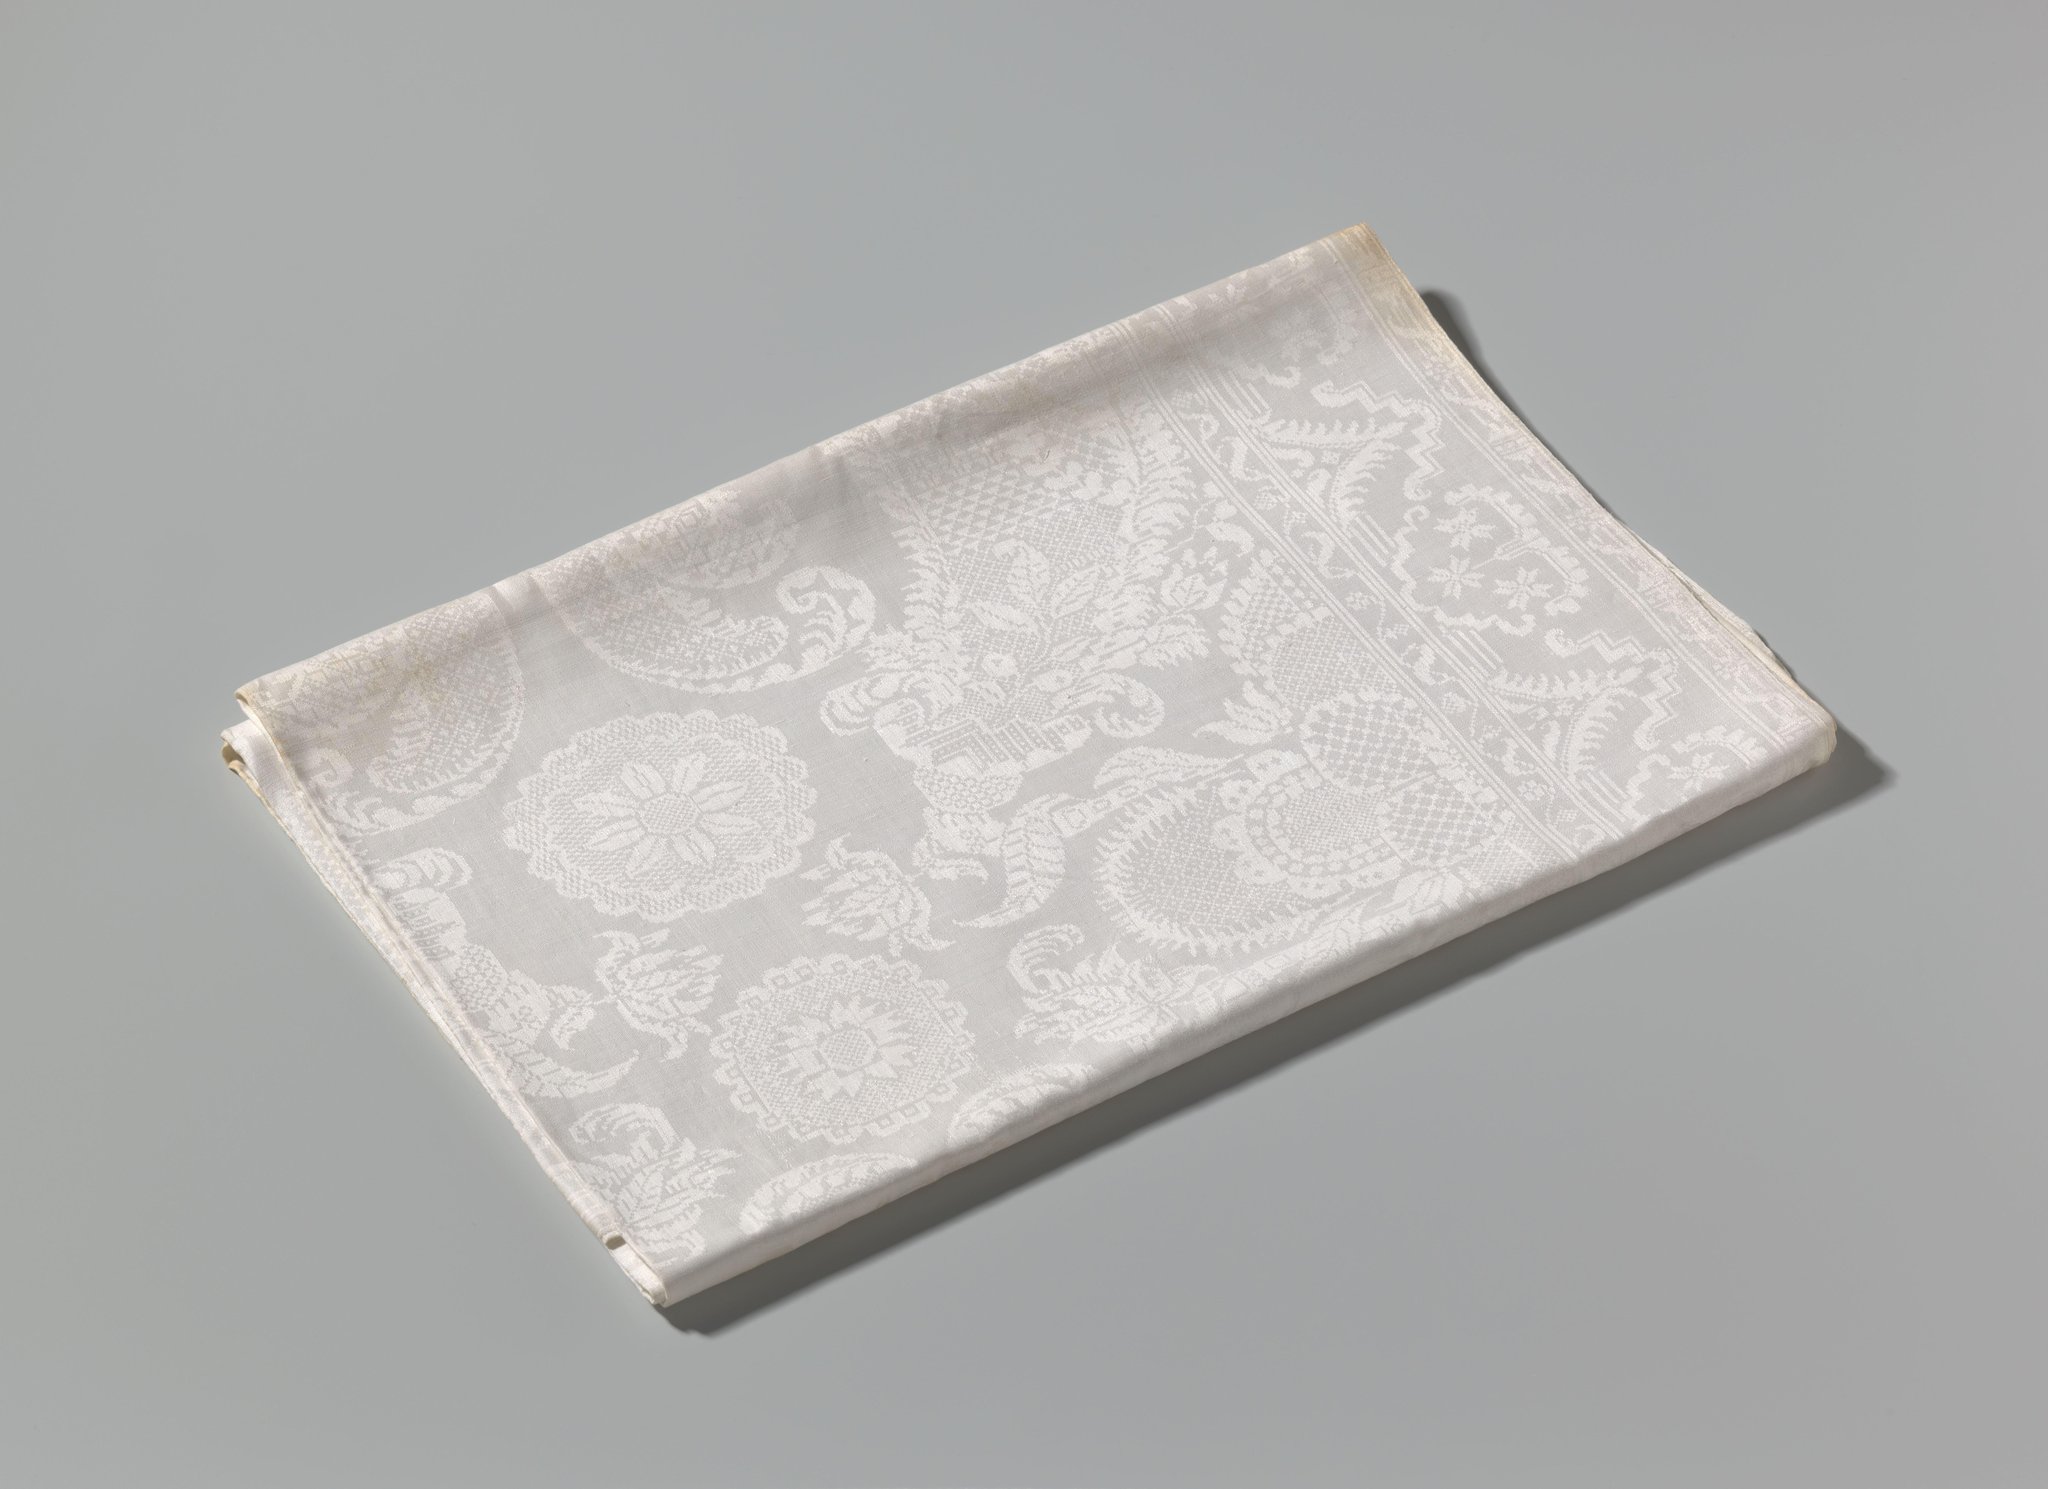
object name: tablecloth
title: Tafellaken met kantpatroon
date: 1723-1730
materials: linen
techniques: damask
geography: northern netherlands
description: Wit linnendamasten tafellaken met een patroon van voluten, merk kroon WG 1.